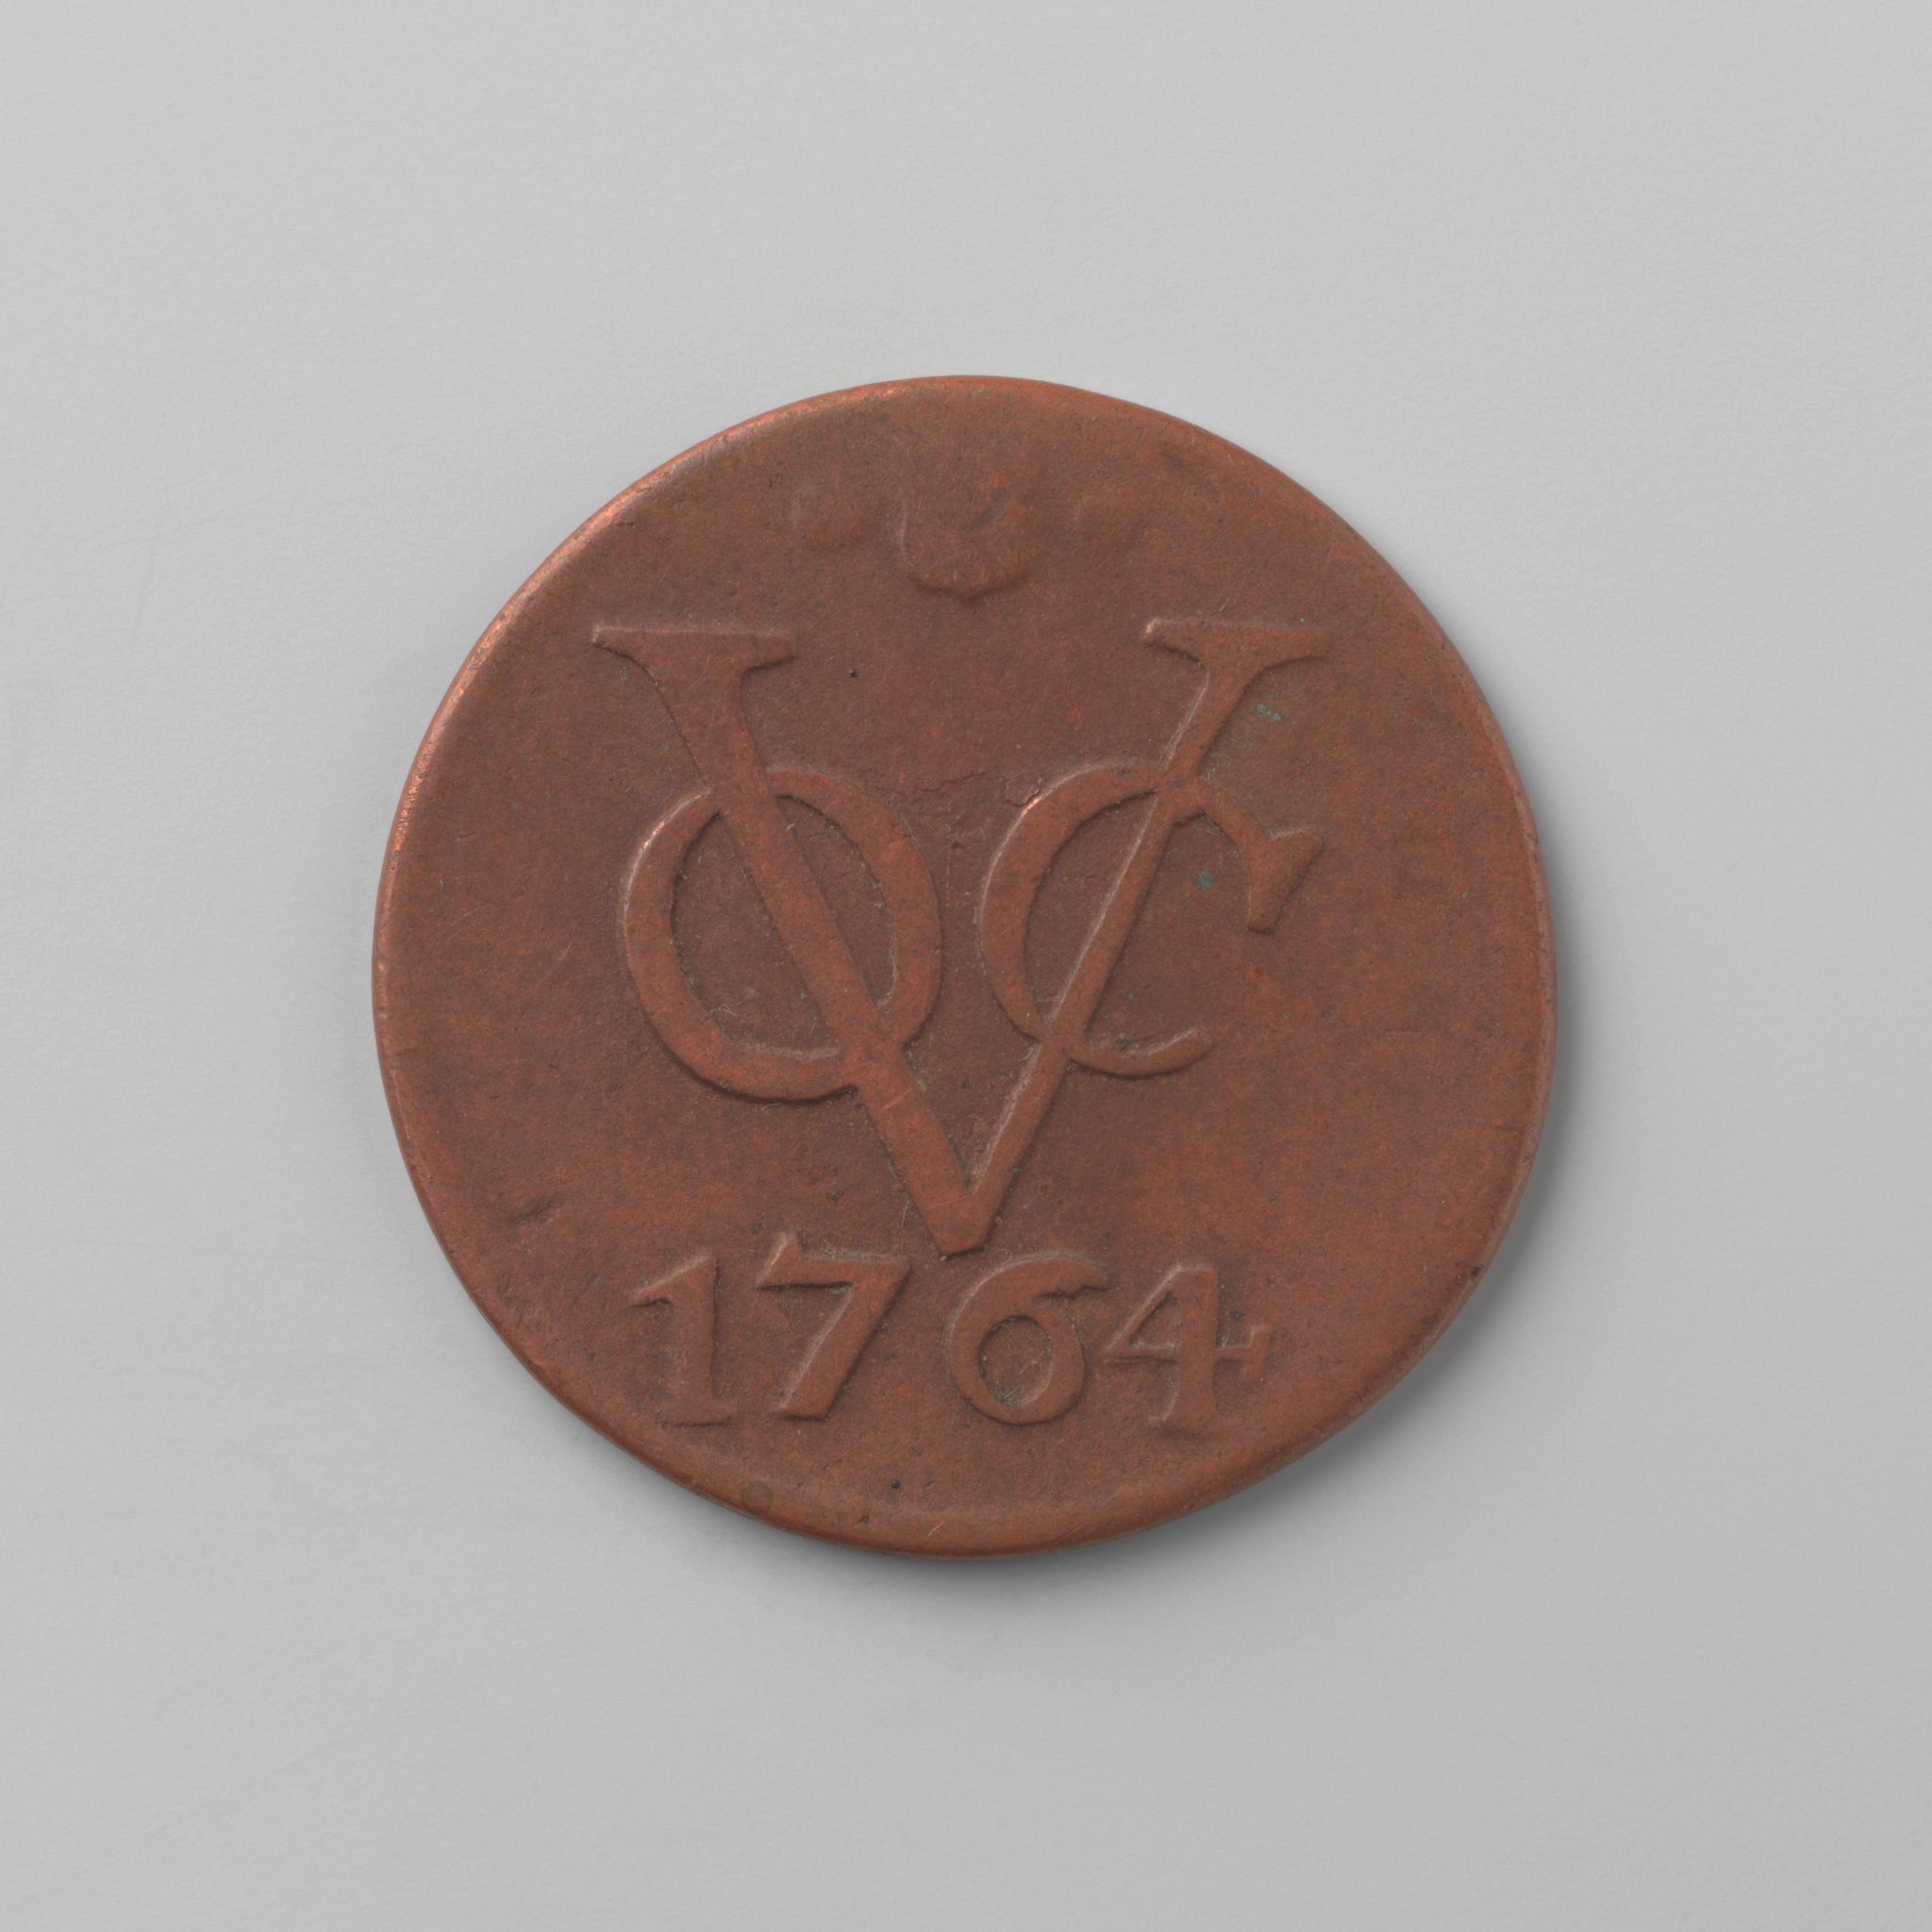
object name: coin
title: Duit van de VOC uit de stad Utrecht,1764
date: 1764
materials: copper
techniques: striking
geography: utrecht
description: Koperen munt. Voorzijde: op balk, waaronder guirlande, geplaatst, door twee leeuwen gehouden gekroond wapenschild van de stad Utrecht. Keerzijde: monogram van de VOC, waarboven muntteken en waaronder jaartal. Gladde rand.